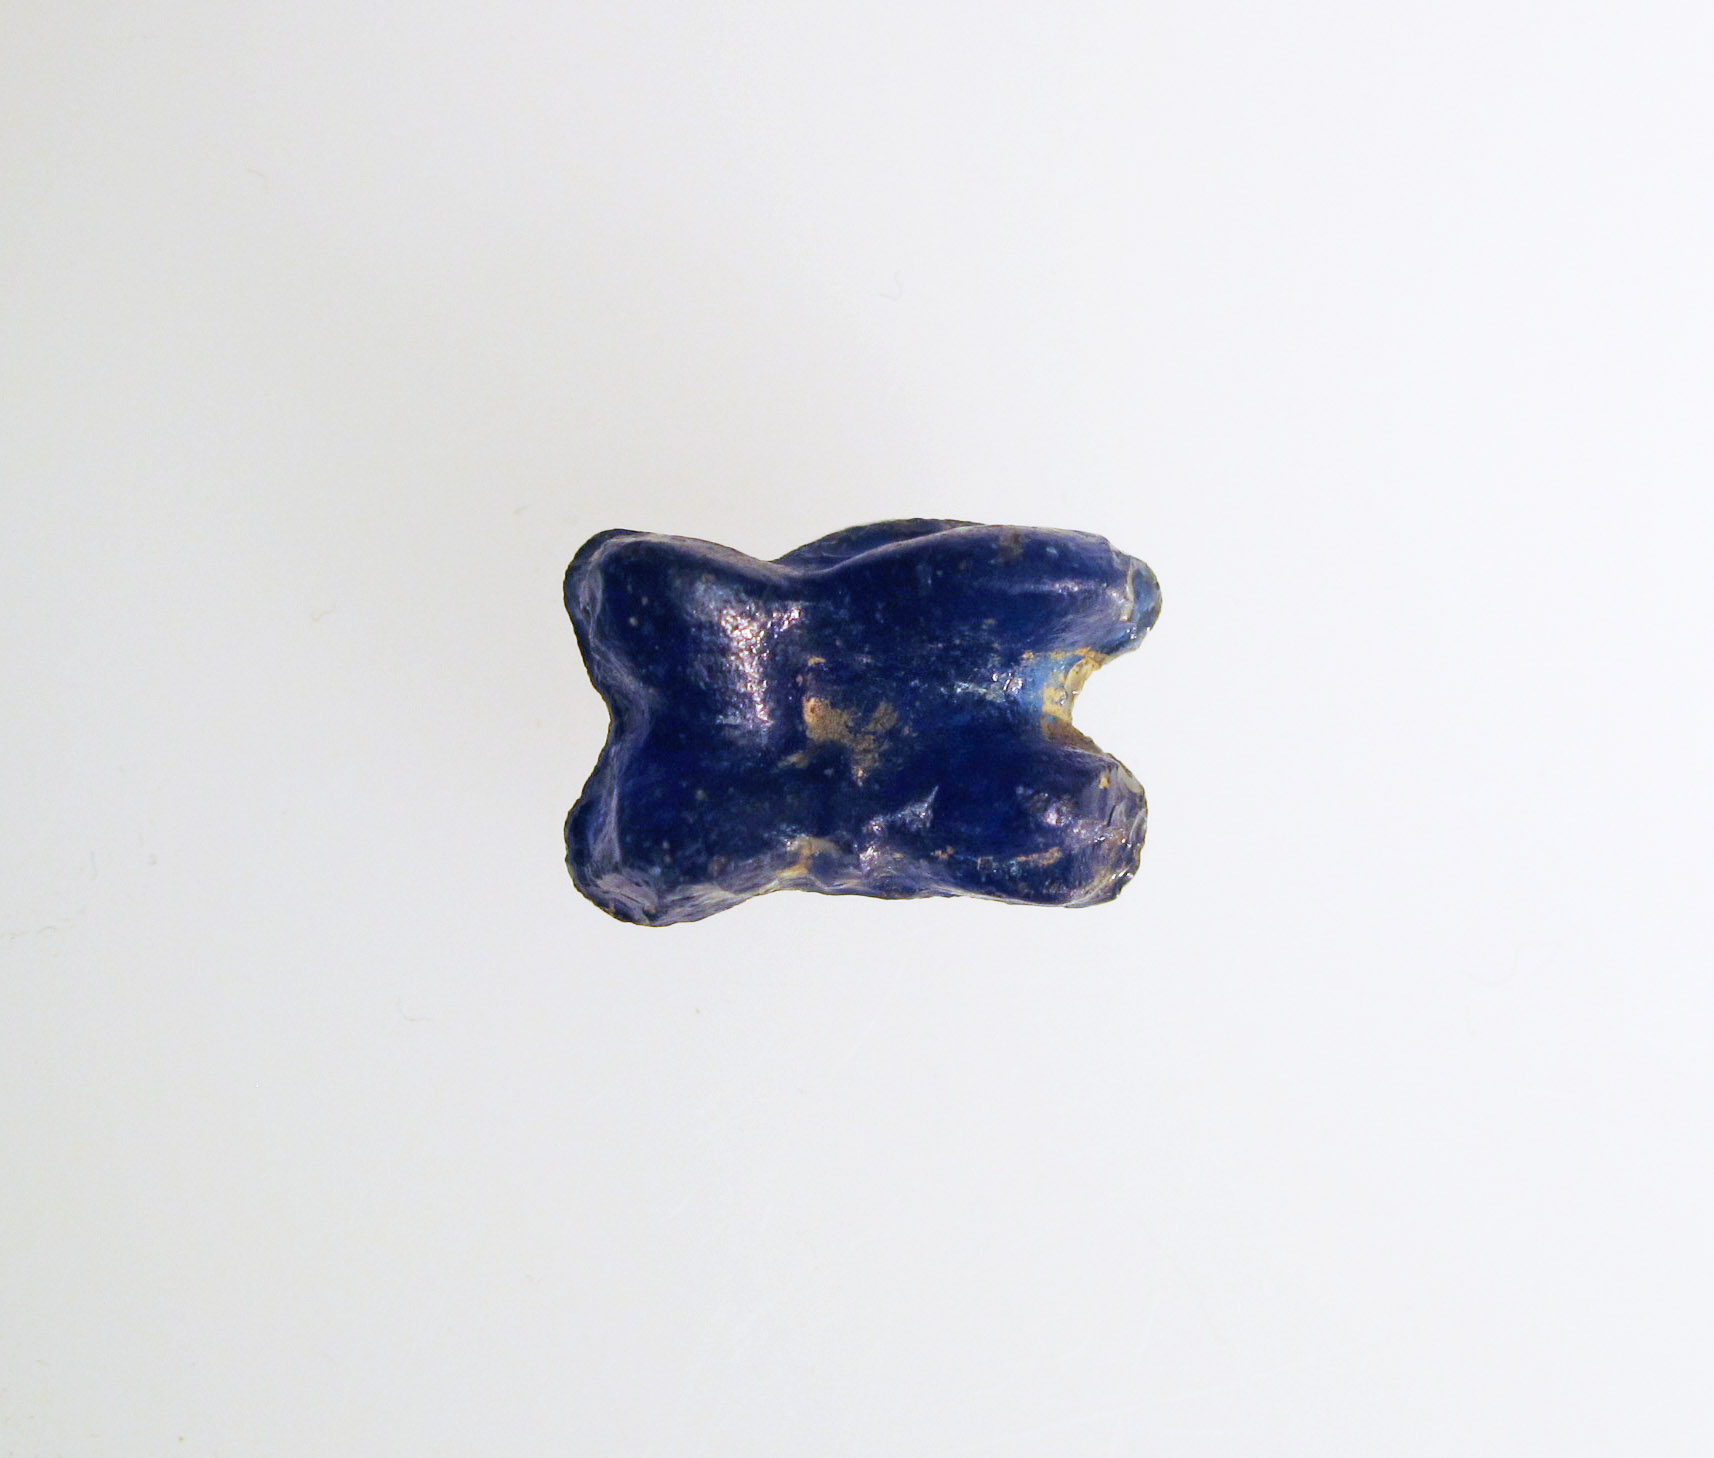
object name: astragal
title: Glass astragal (knucklebone)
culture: greek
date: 300-101 BCE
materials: glass